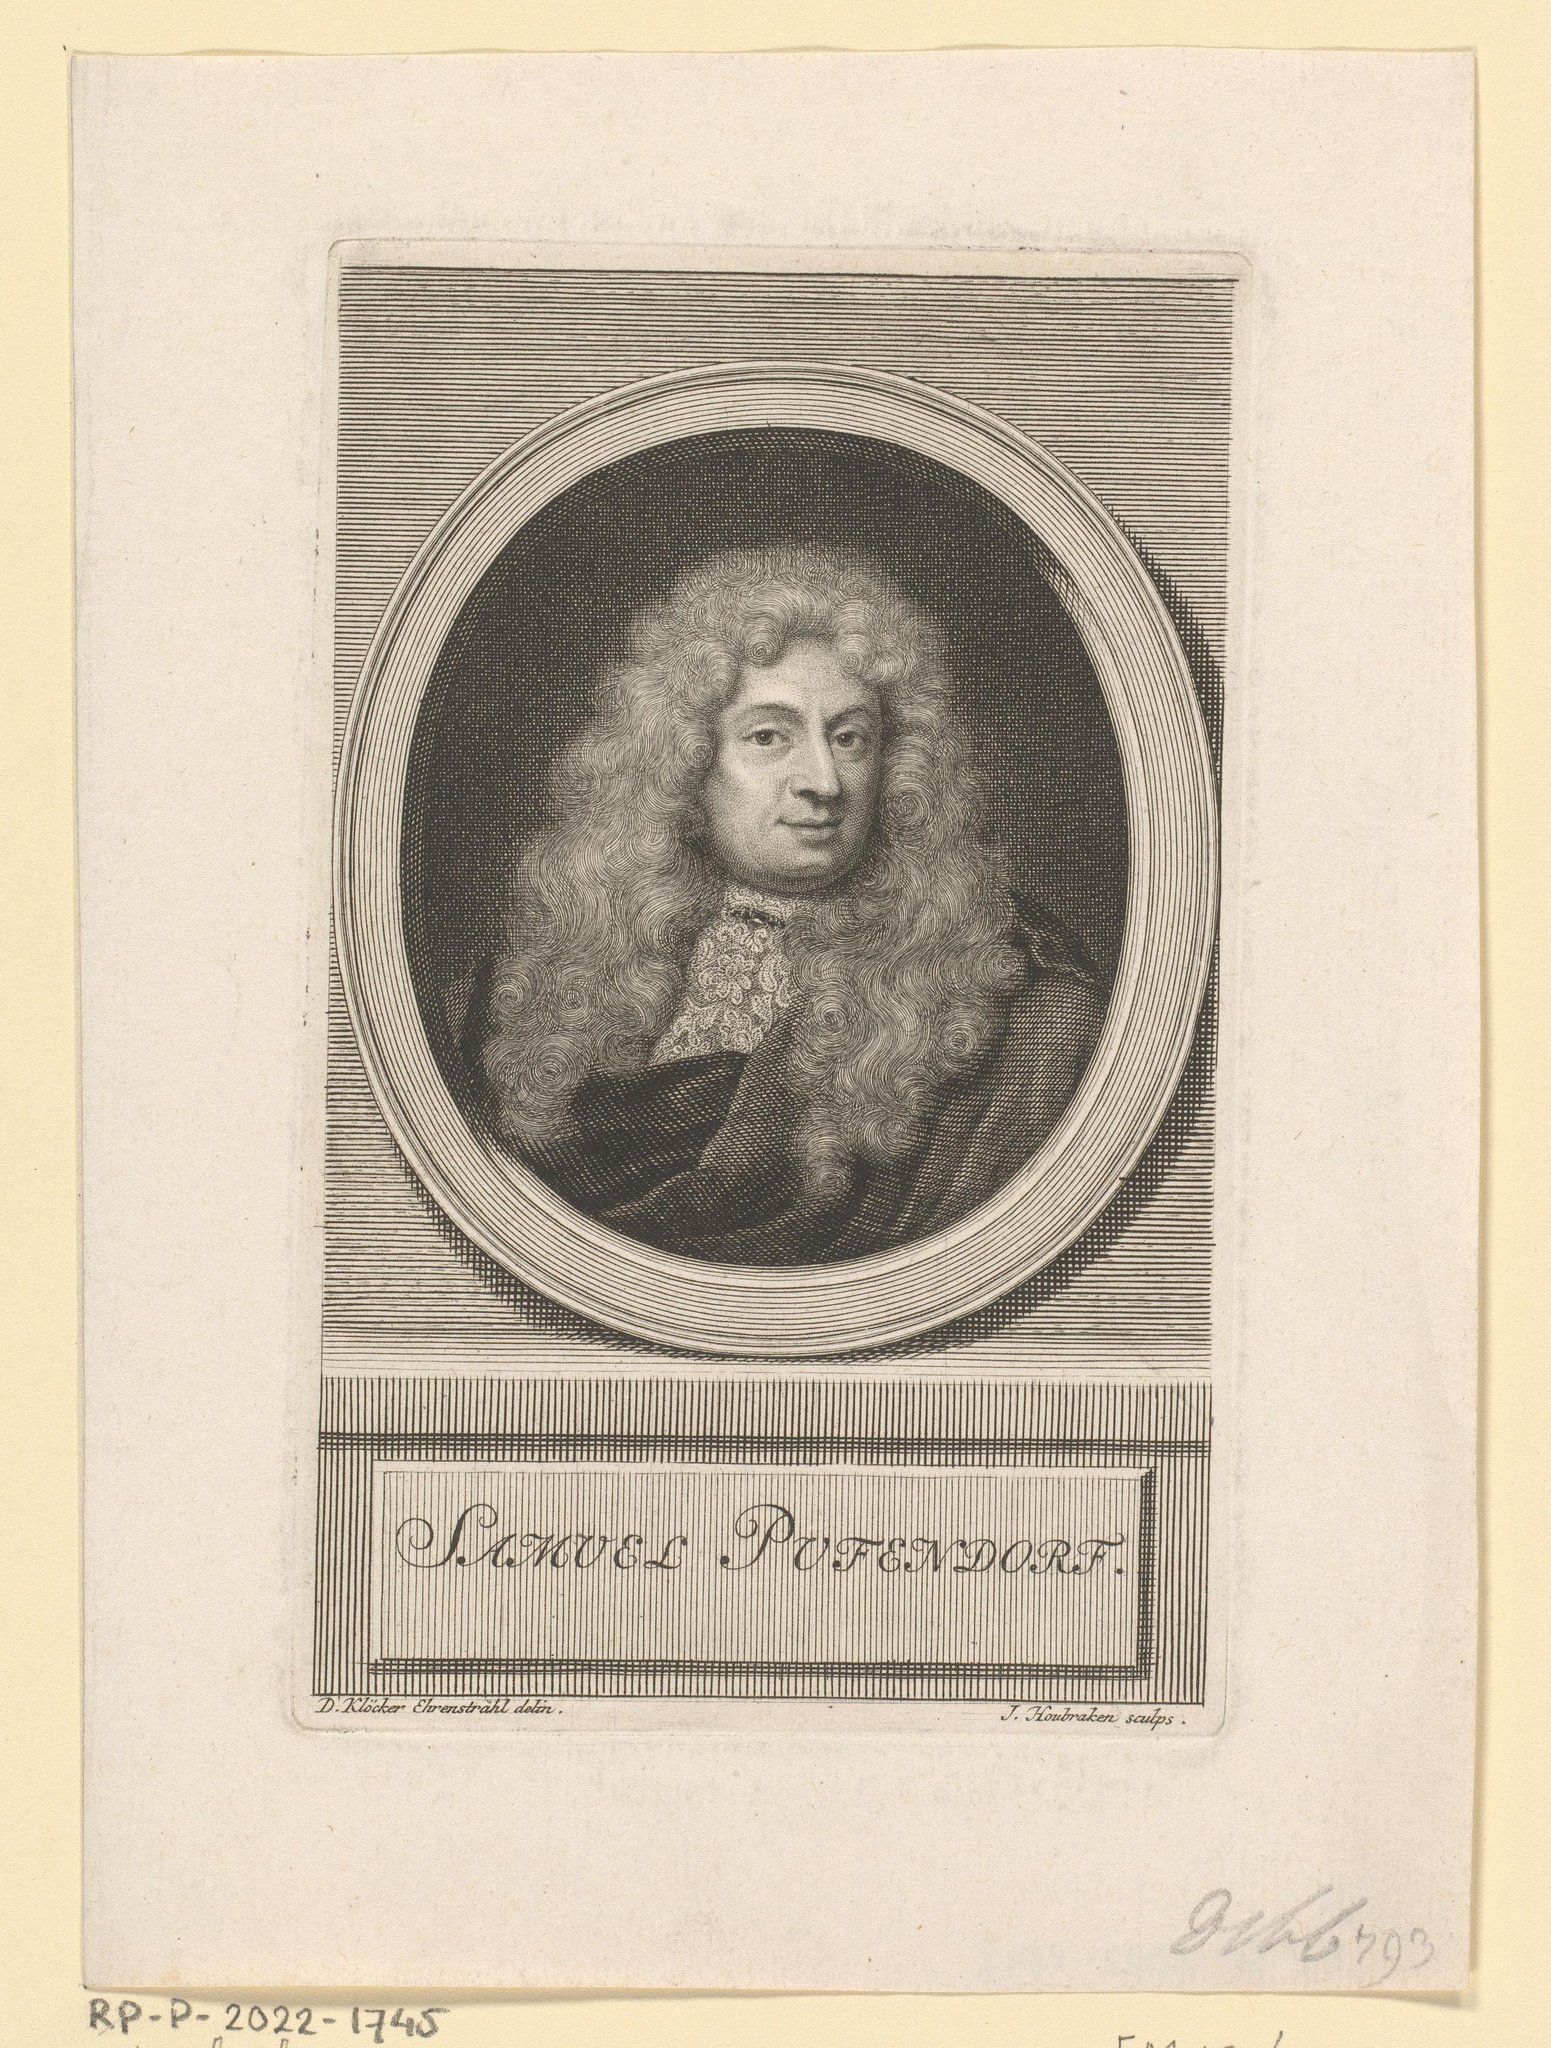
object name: print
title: Portret van Samuel von Pufendorf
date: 1735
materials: paper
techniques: engraving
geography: amsterdam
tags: berlin, history and archaeology (+ portrait of scholar, scientist), scholar, philosopher, historical persons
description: Prent waarschijnlijk uit: Pufendorf, Samuel von. Les devoirs de l'Homme, et du citoien, tels qu'ils lui sont prescrits par la Loi Naturelle (...). Amsterdam: weduwe P. de Coup & G. Kuyper, 1735.